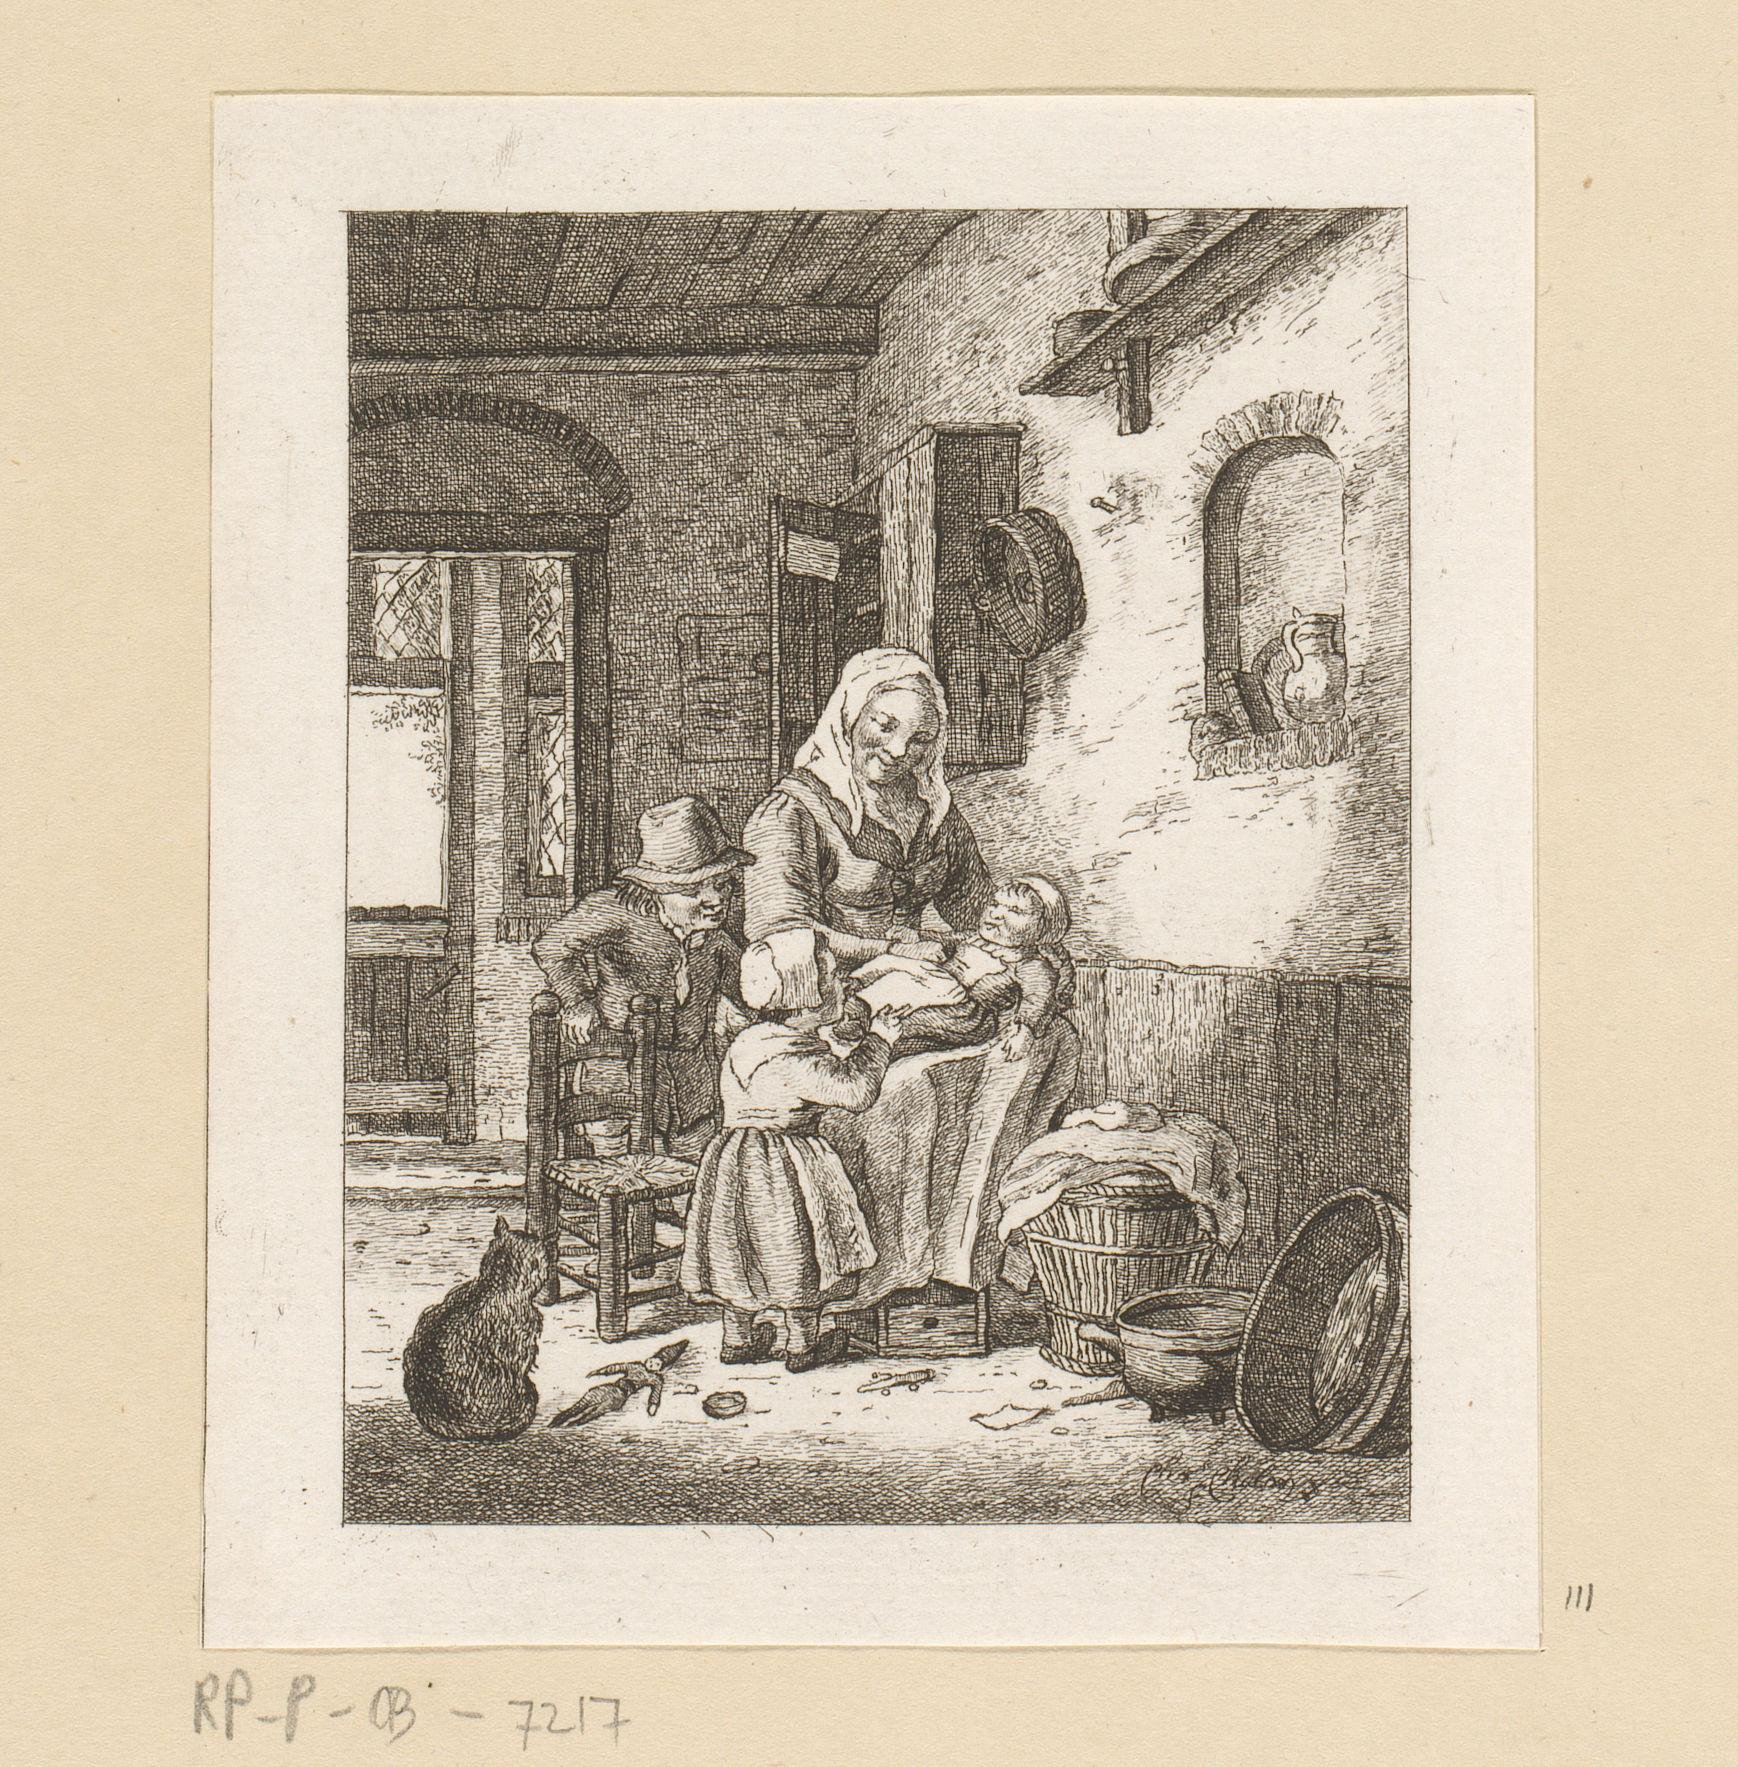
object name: print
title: Moeder met kinderen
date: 1779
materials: paper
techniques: etching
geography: leiden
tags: cat, mother and child(ren), woman and child(ren) (family group) (with number of children), rocking the baby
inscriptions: collector's mark: Lugt 2228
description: Een vrouw in een keuken. Ze zit op een stoel en draagt een baby in haar armen. Haar twee andere kinderen, een jongen en een meisje, bezichtigen het kind. Op de grond ligt wat speelgoed en een mand met wasgoed. Een kat zit links in de de hoek.